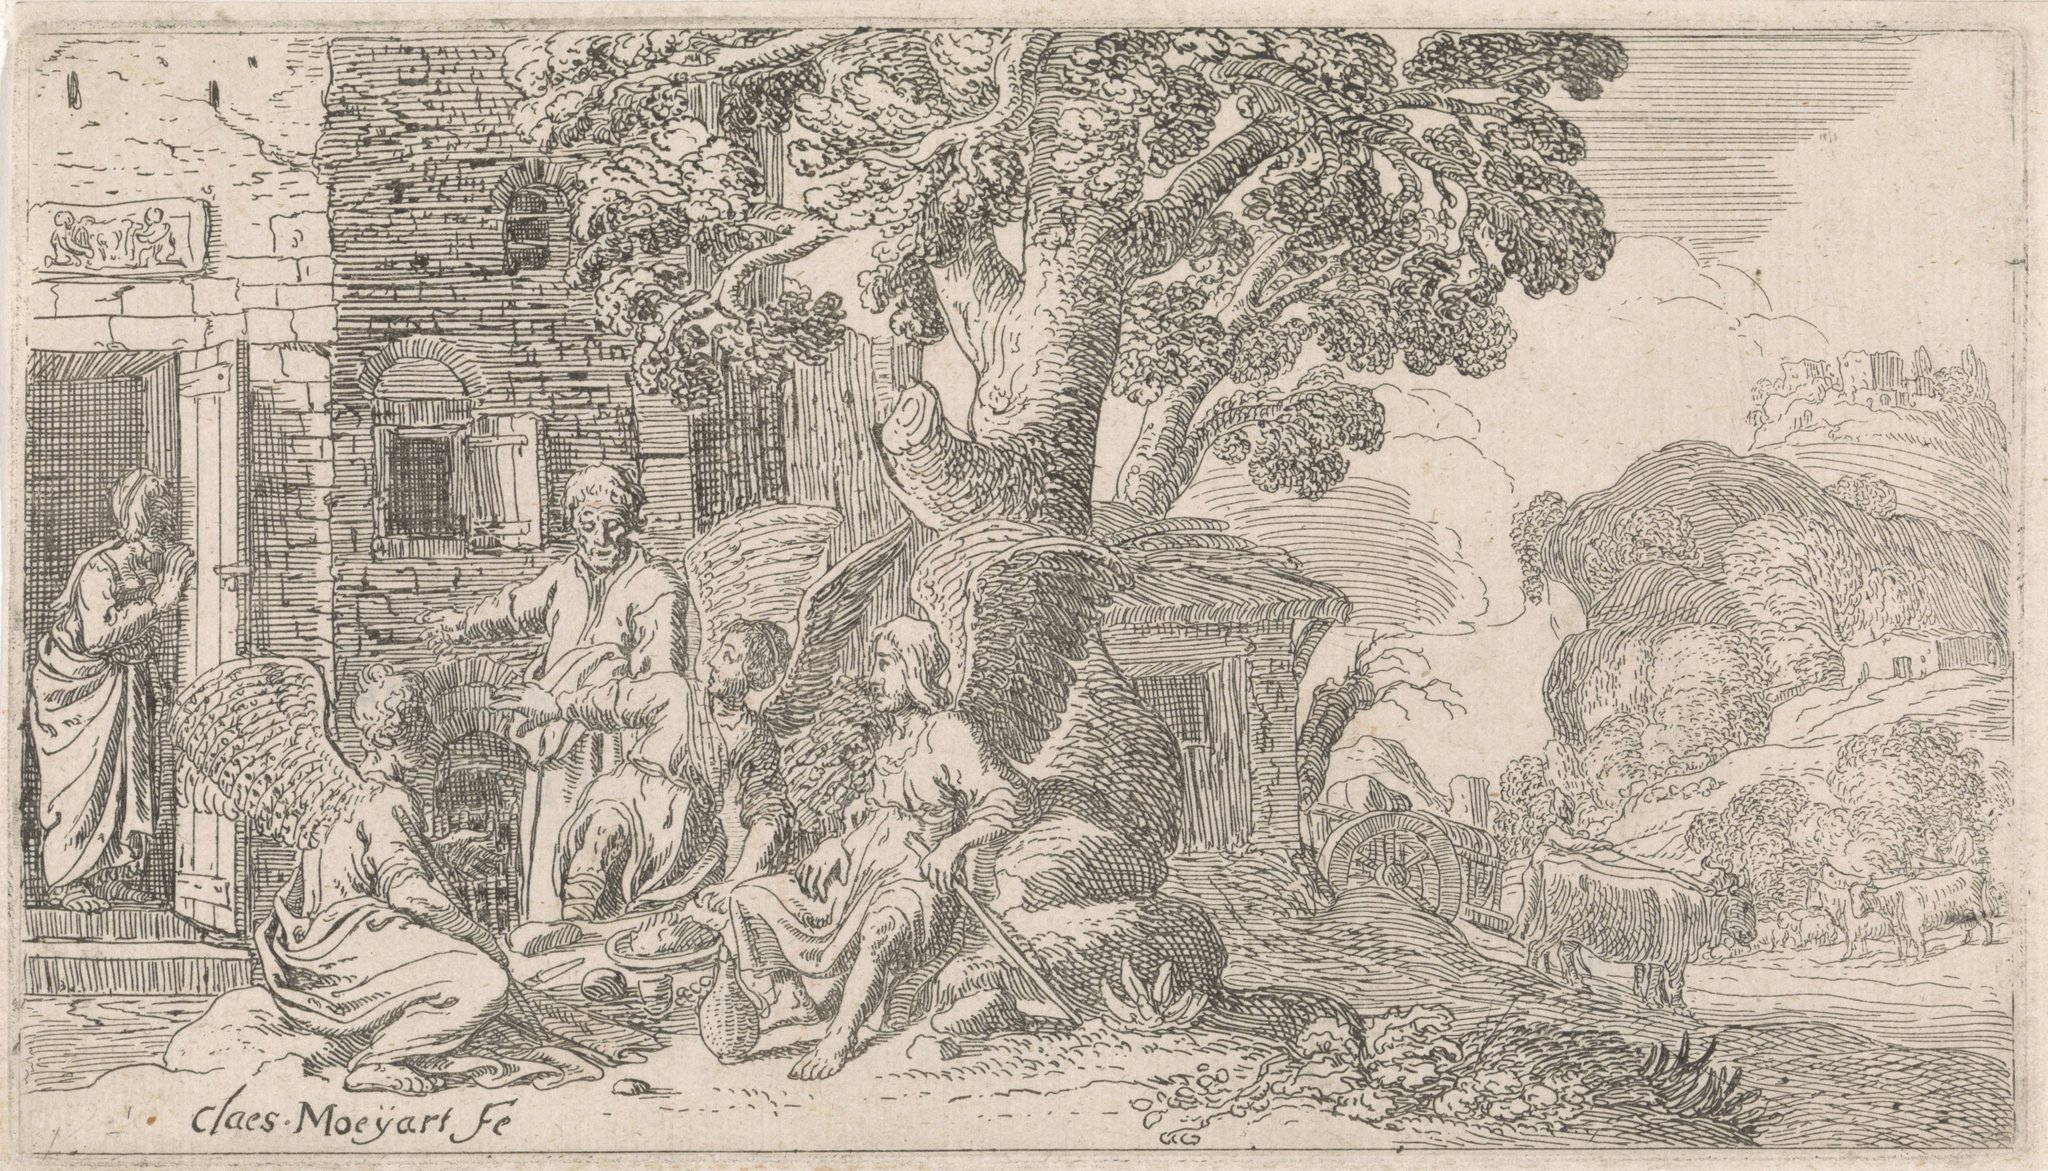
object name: print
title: Abraham en de engelen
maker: claes moeyaert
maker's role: draughtsman, painter, print maker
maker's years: 1592-1655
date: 1612-1655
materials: paper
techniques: etching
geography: amsterdam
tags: abraham entertaining the three angels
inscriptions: collector's mark: Lugt 2228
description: Abraham krijgt de drie engelen op bezoek en zit met hen onder een boom. In de deuropening staat Sara.